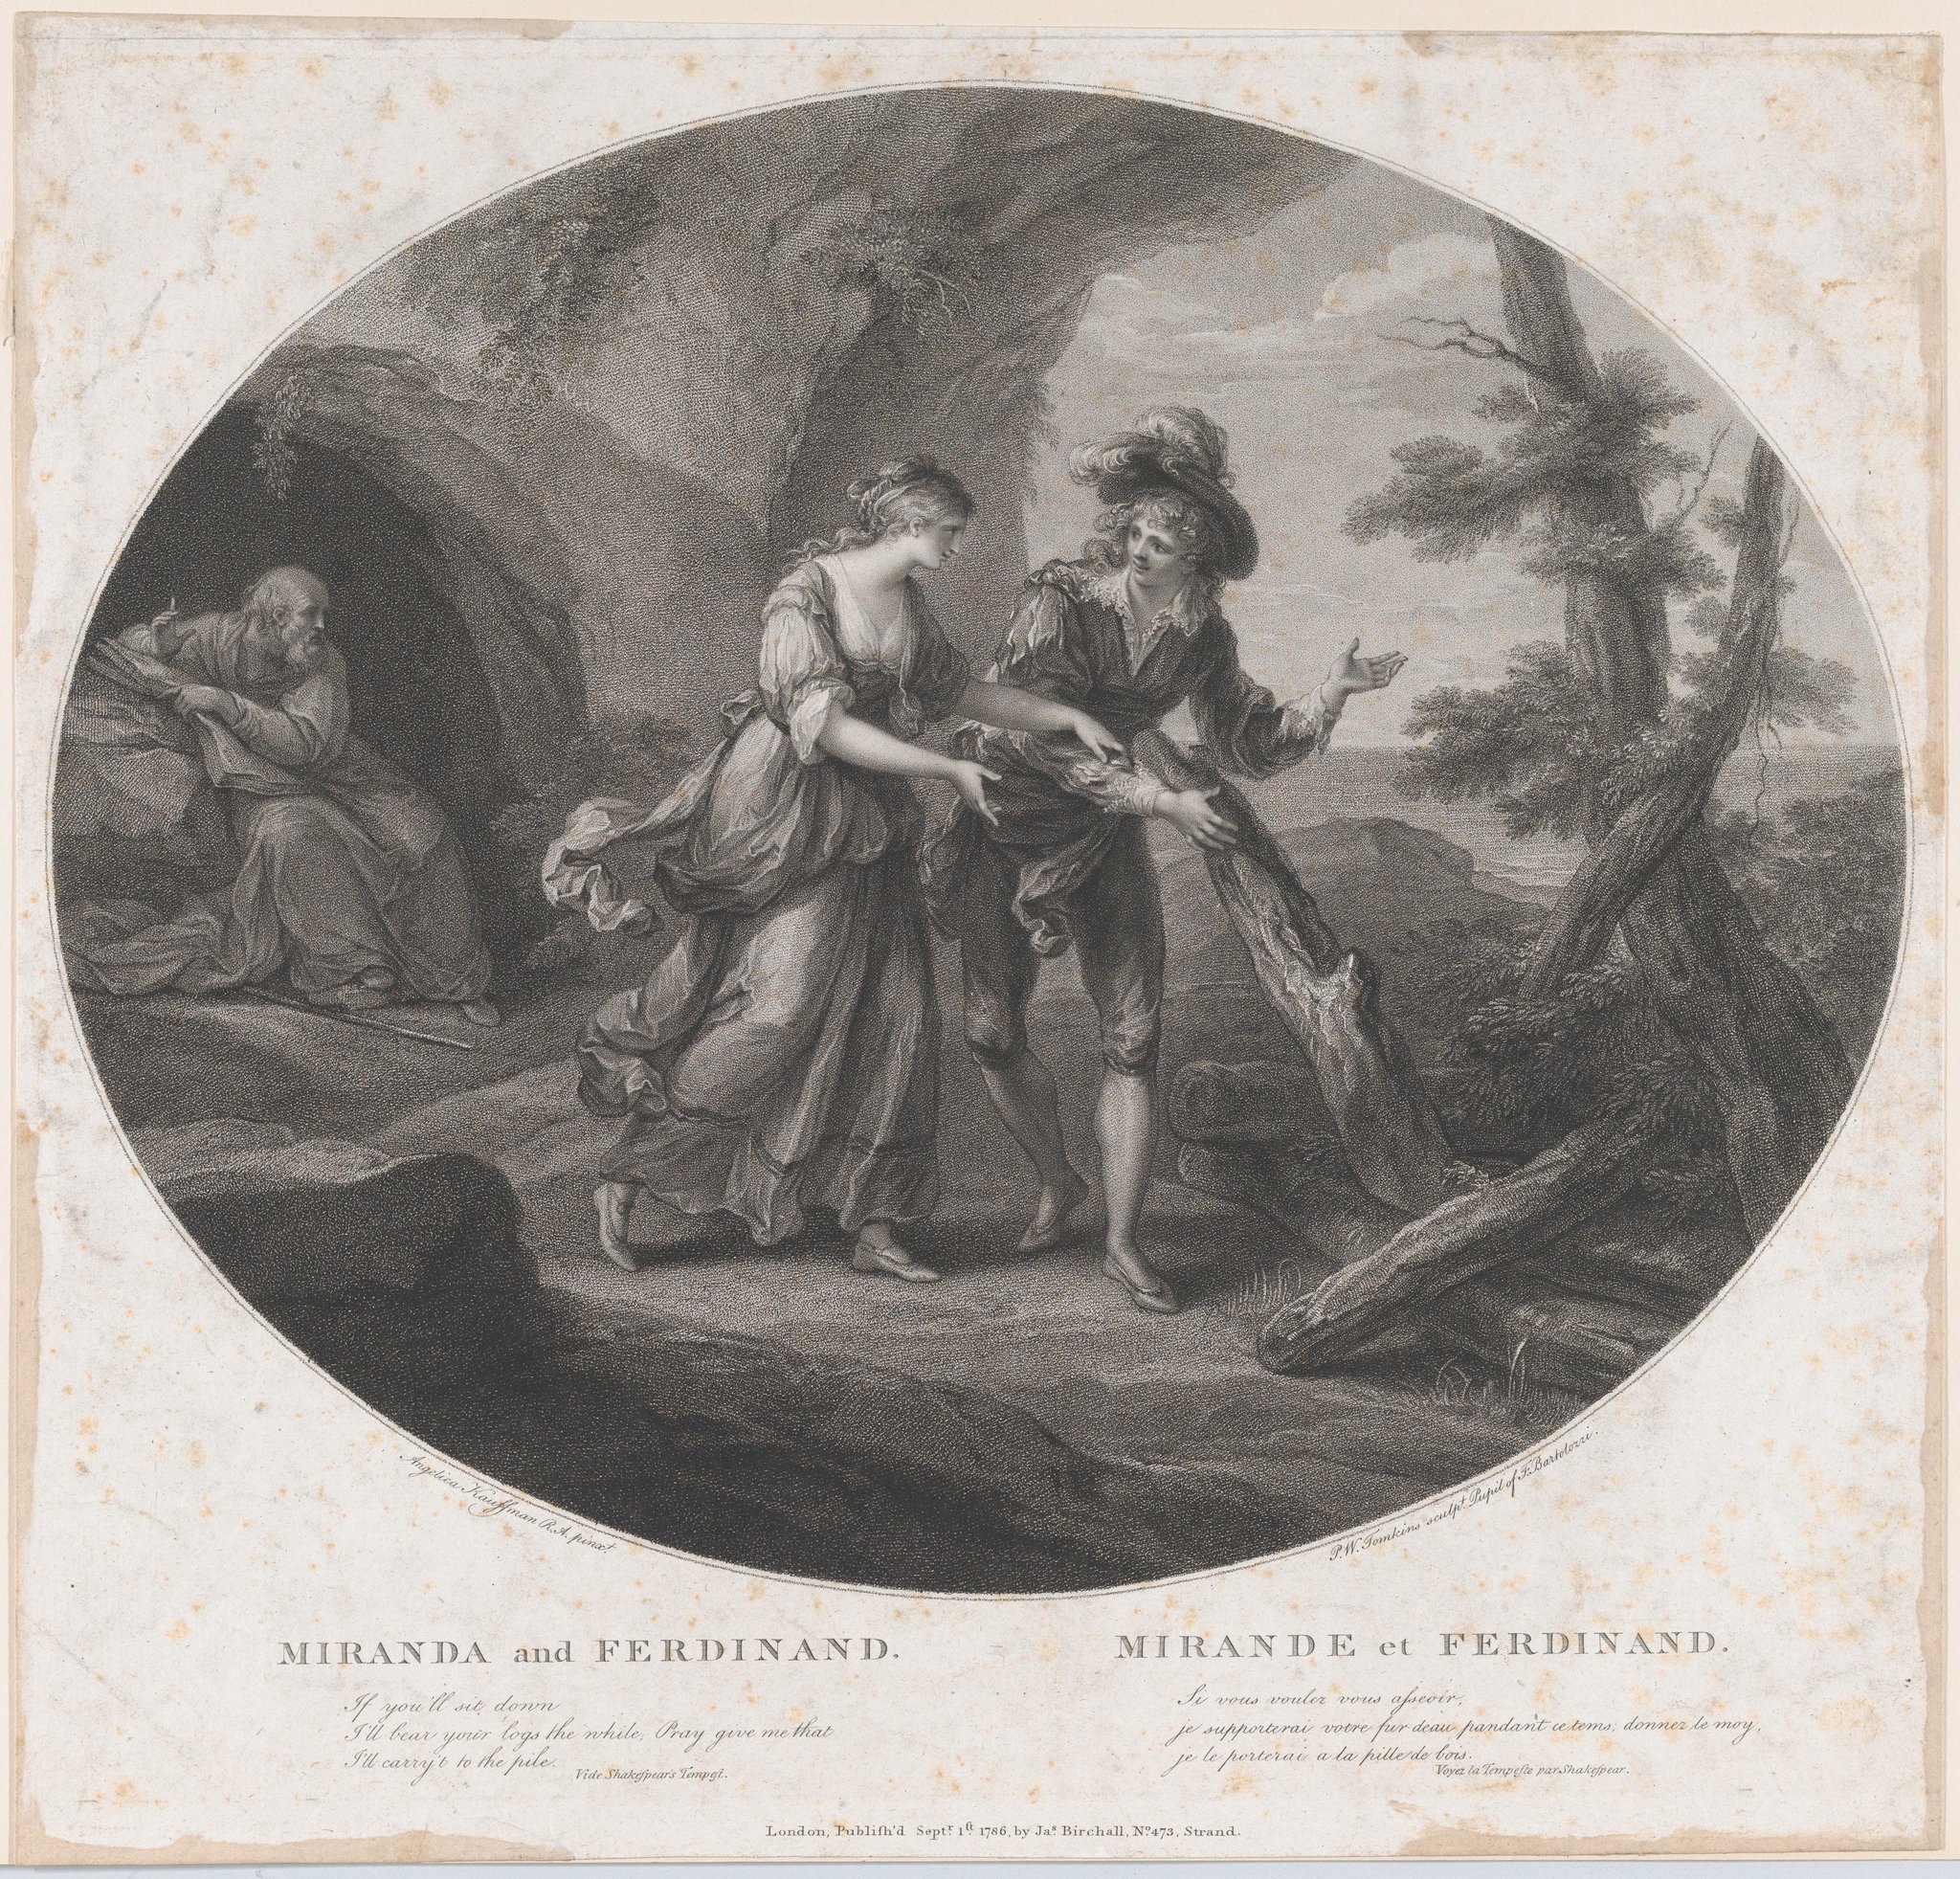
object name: print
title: Ferdinand and Miranda (Shakespeare, The Tempest, Act 3, Scene 1)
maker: peltro william tomkins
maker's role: engraver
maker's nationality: british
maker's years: 1759-1840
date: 1786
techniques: etching, engraving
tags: shakespeare,men,women